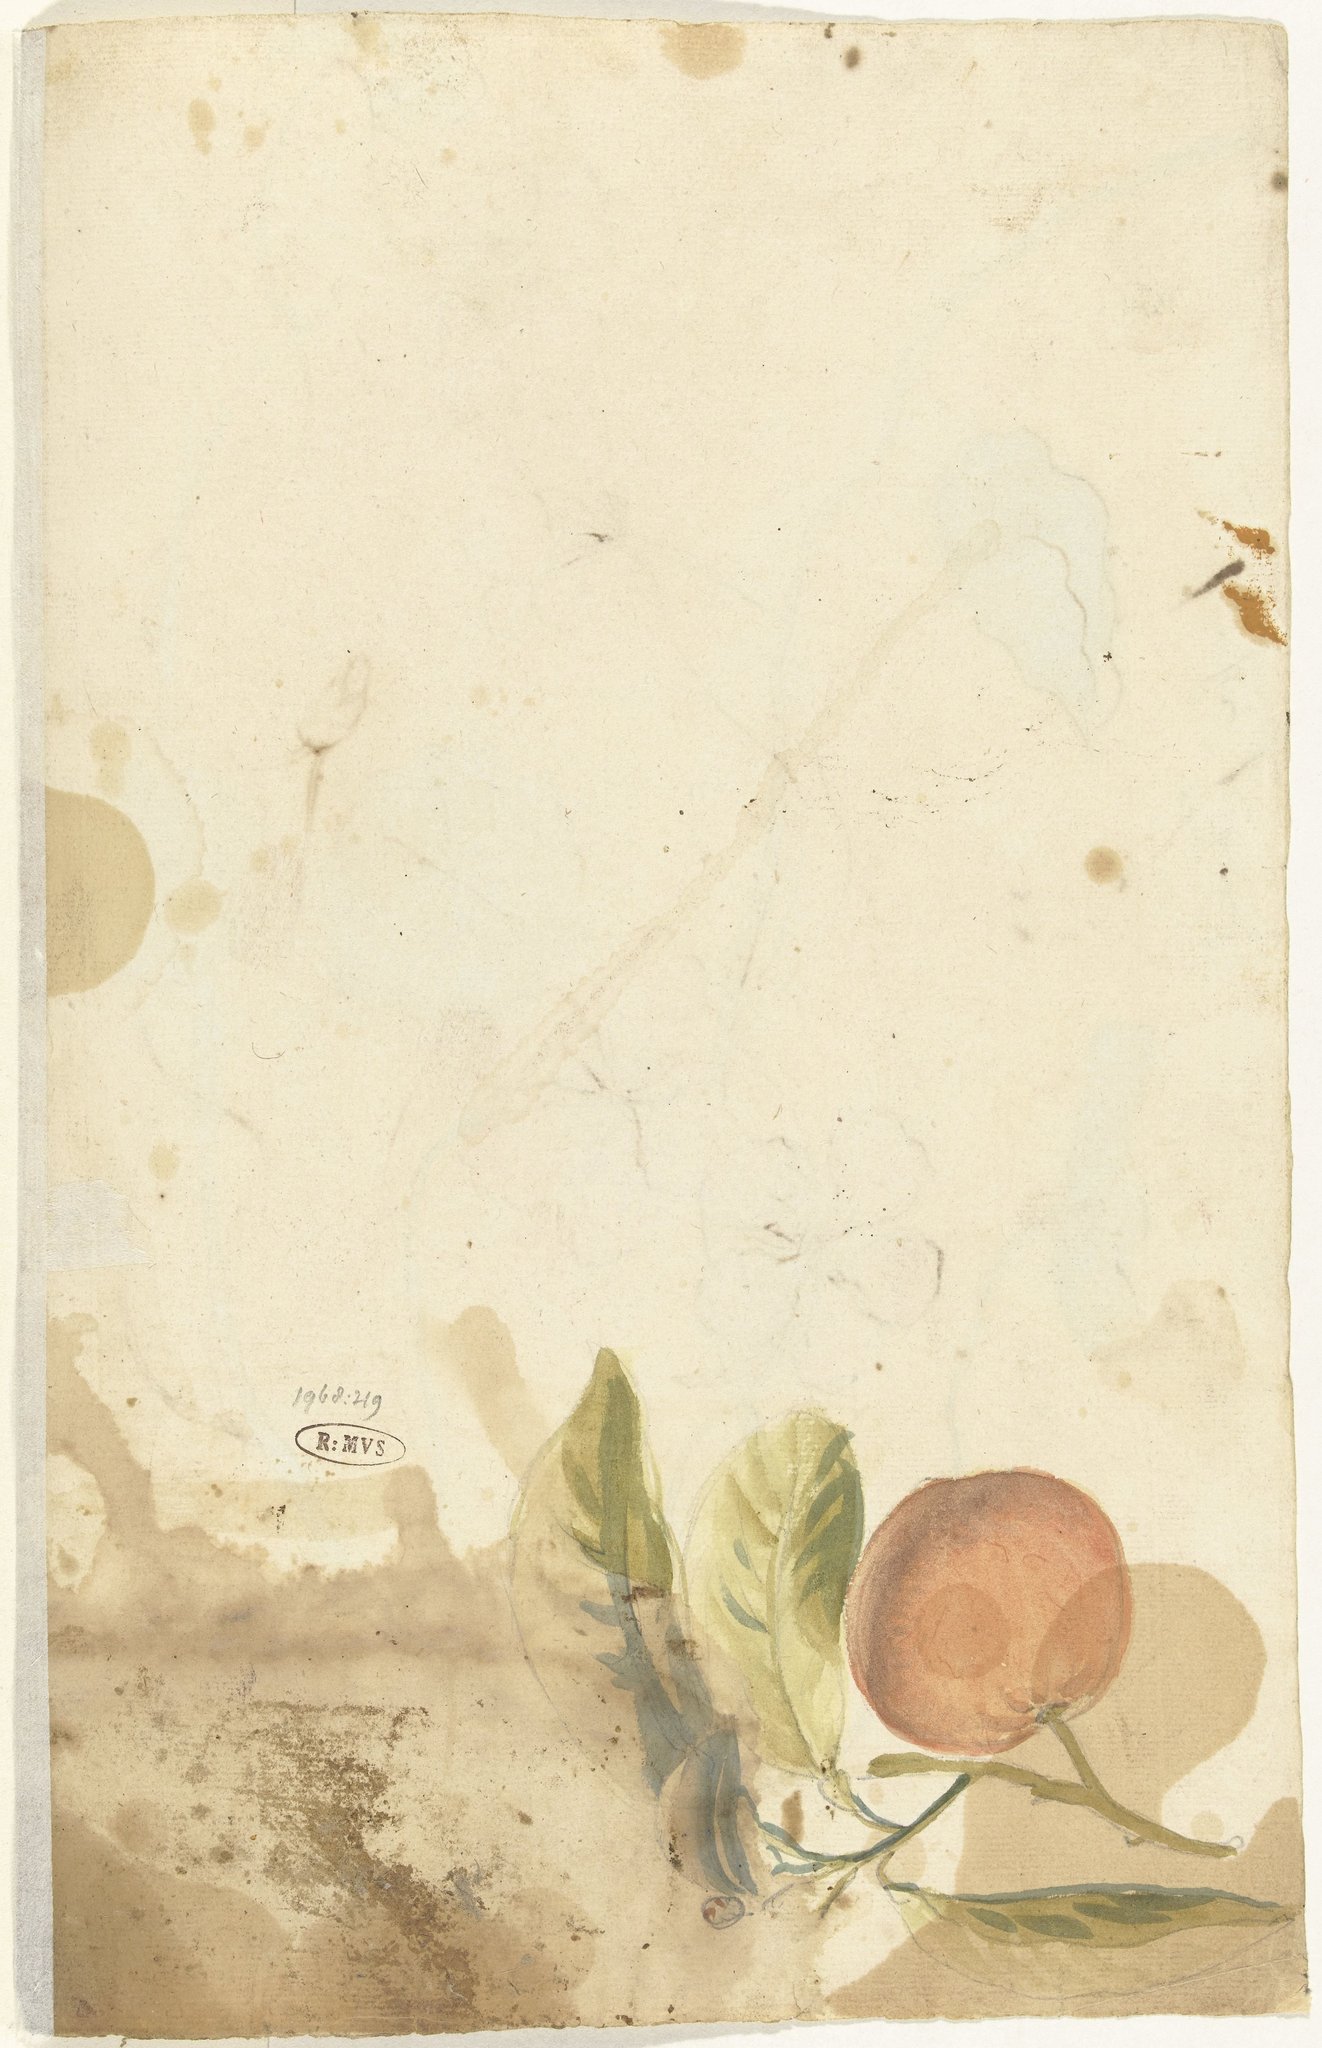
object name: drawing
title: Sinaasappel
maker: elias van nijmegen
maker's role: draughtsman, painter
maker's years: 1667-1755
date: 1677-1755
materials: paper, pencil, watercolor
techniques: brush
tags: fruits: orange